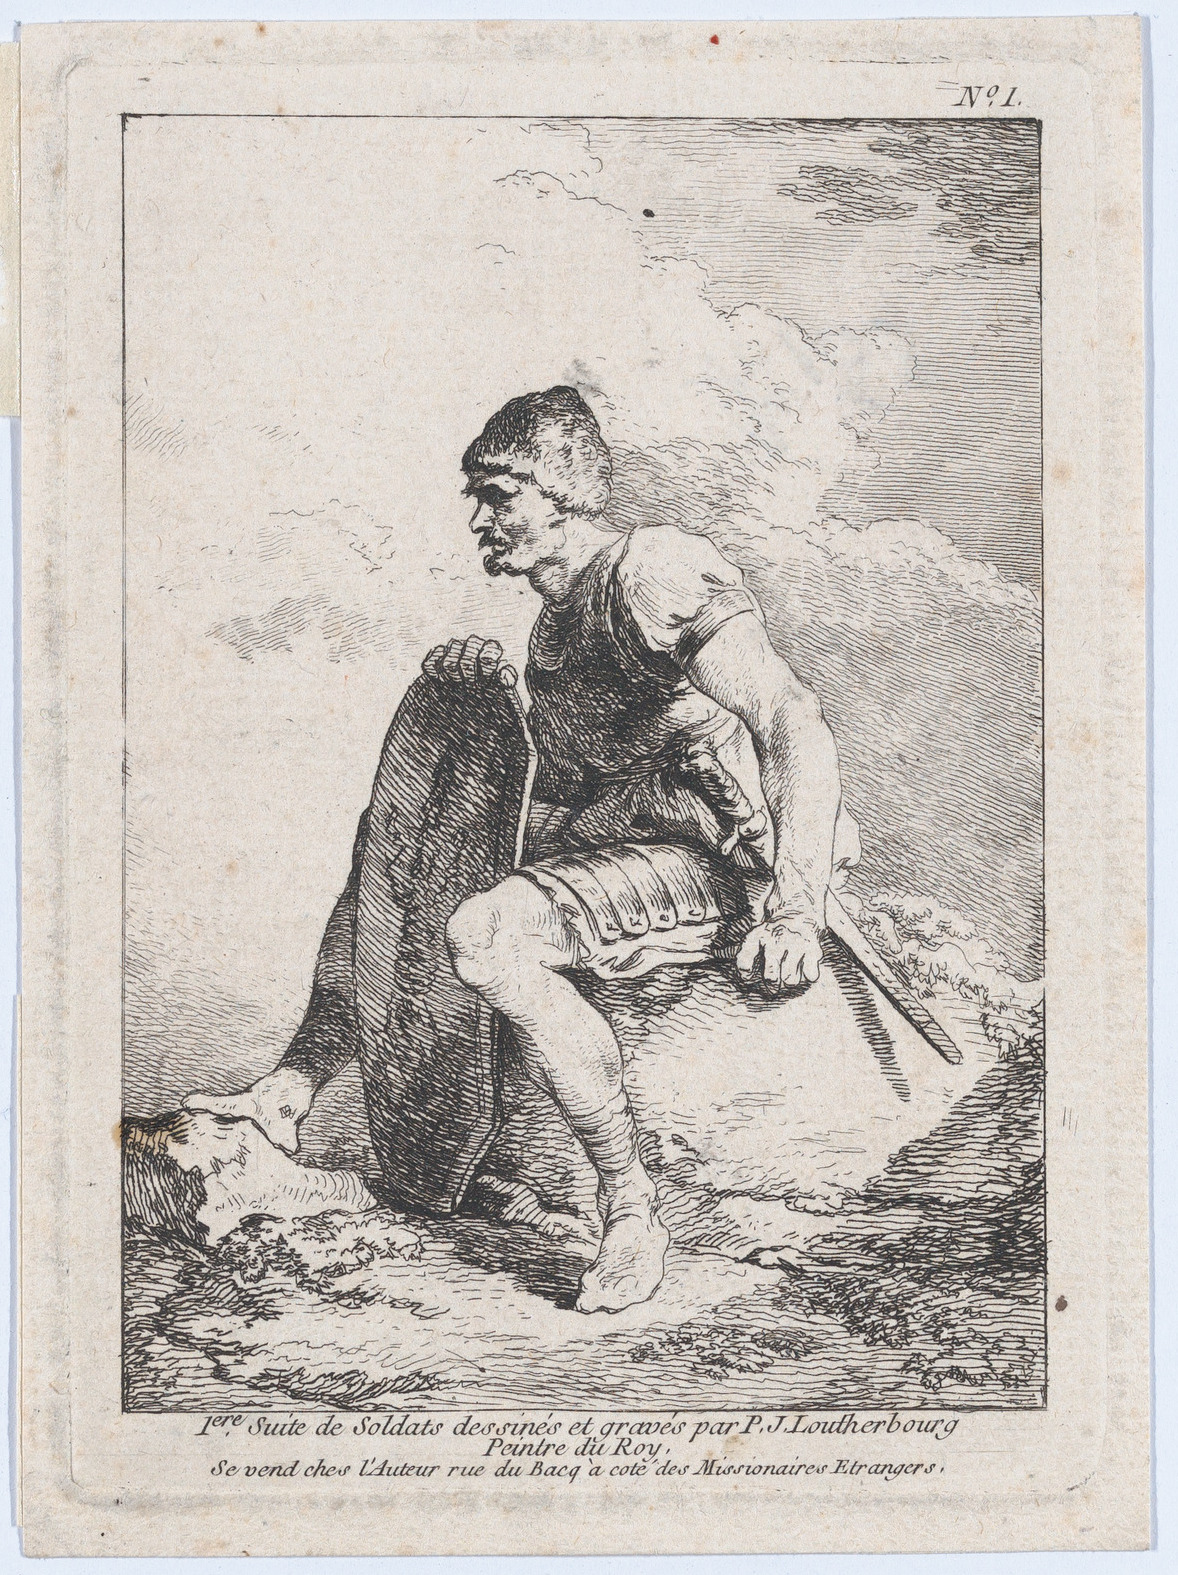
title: Seated Soldier Holding a Shield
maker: philippe jacques de loutherbourg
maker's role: artist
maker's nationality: french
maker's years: 1740-1812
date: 1755-1771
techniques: etching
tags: soldiers,shields,men